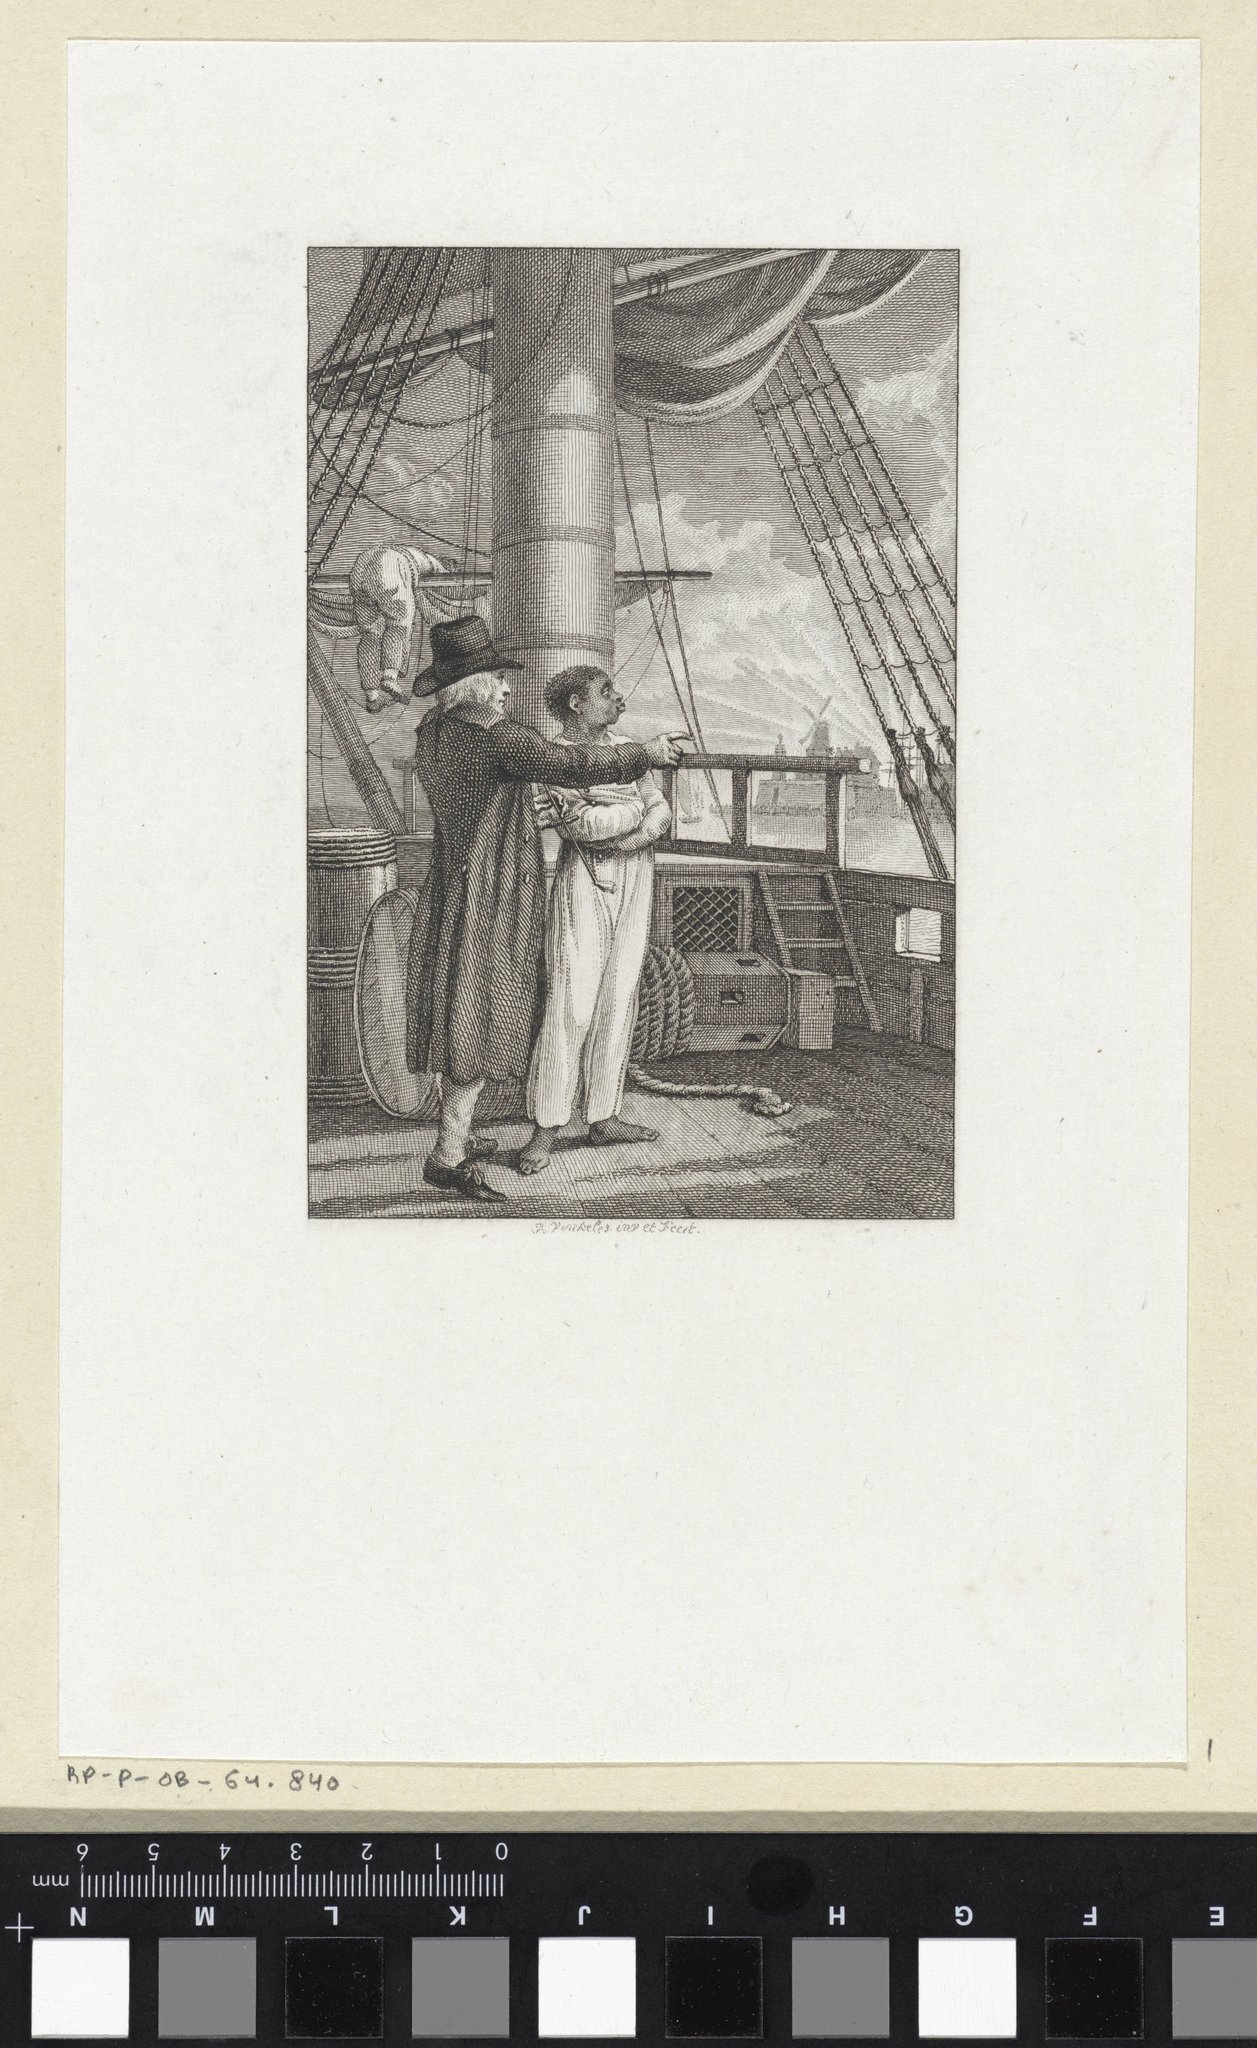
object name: print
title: Marines laat een Afrikaanse man vanaf een boot Vlissingen zien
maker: reinier vinkeles (i)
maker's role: draughtsman, print maker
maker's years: 1741-1816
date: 1804-1805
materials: paper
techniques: engraving, etching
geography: amsterdam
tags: sailing-ship, sailing-boat, africans, pipe ~ tobacco, index finger forwards, pointing, indicating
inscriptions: collector's mark: Lugt 240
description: Proefdruk van illustratie die ook gebruikt is in: Loosjes, Adriaan Pietersz. Zedelijke Verhaalen. Haarlem: Adriaan Loosjes, 1804-1805. Tweede druk Haarlem: Adriaan Loosjes, 1815.